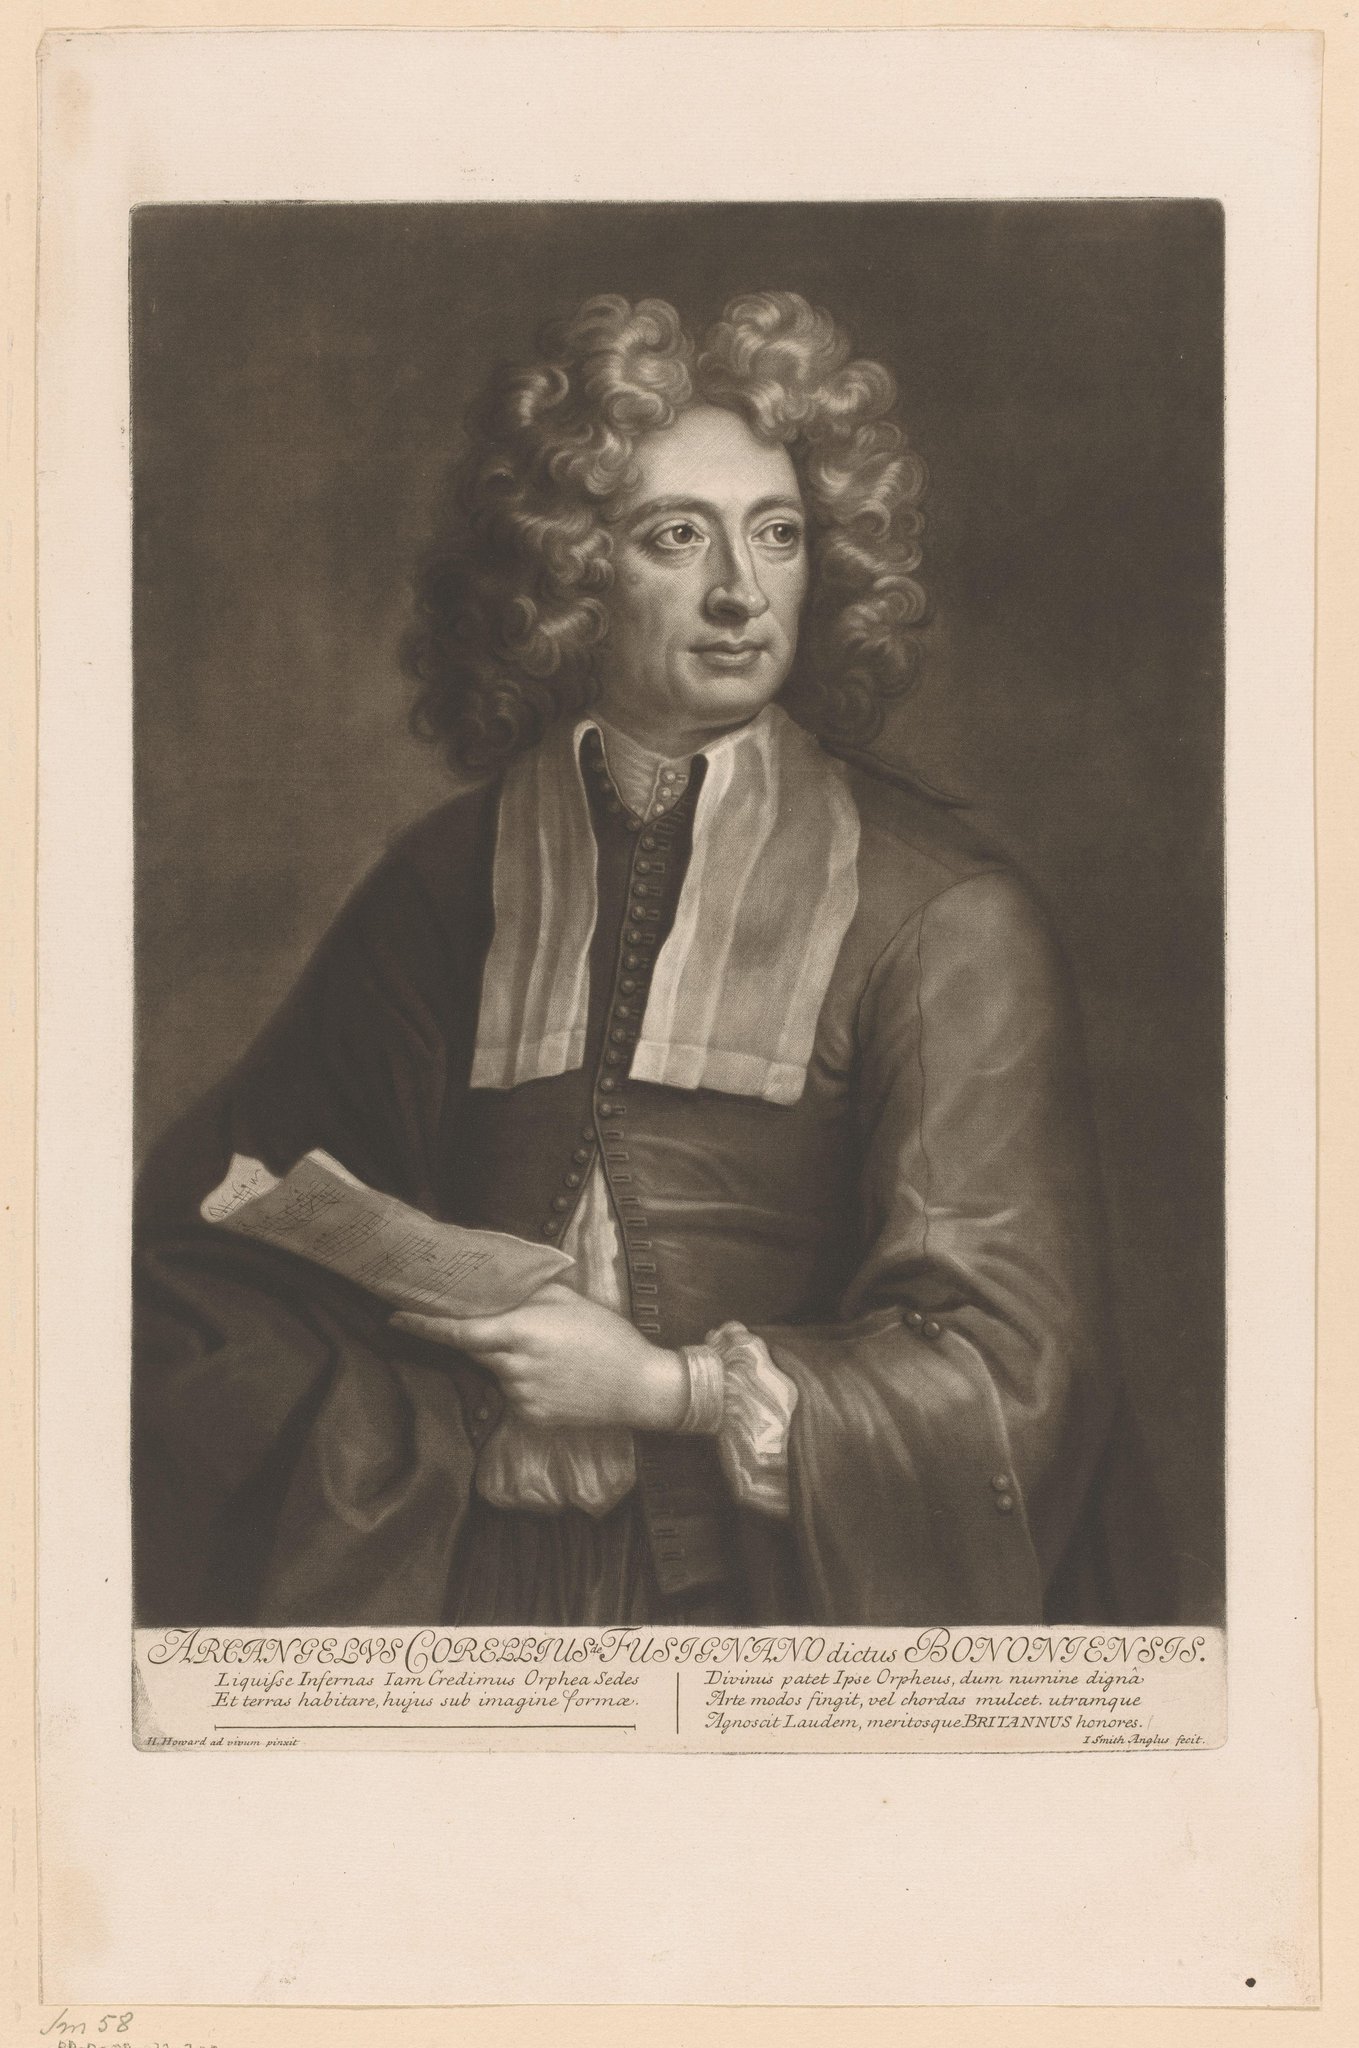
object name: print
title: Portret van Arcangelo Corelli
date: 1662-1742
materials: paper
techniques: mezzotint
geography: england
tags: rome, historical persons, portrait of a musician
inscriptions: collector's mark: Lugt 240